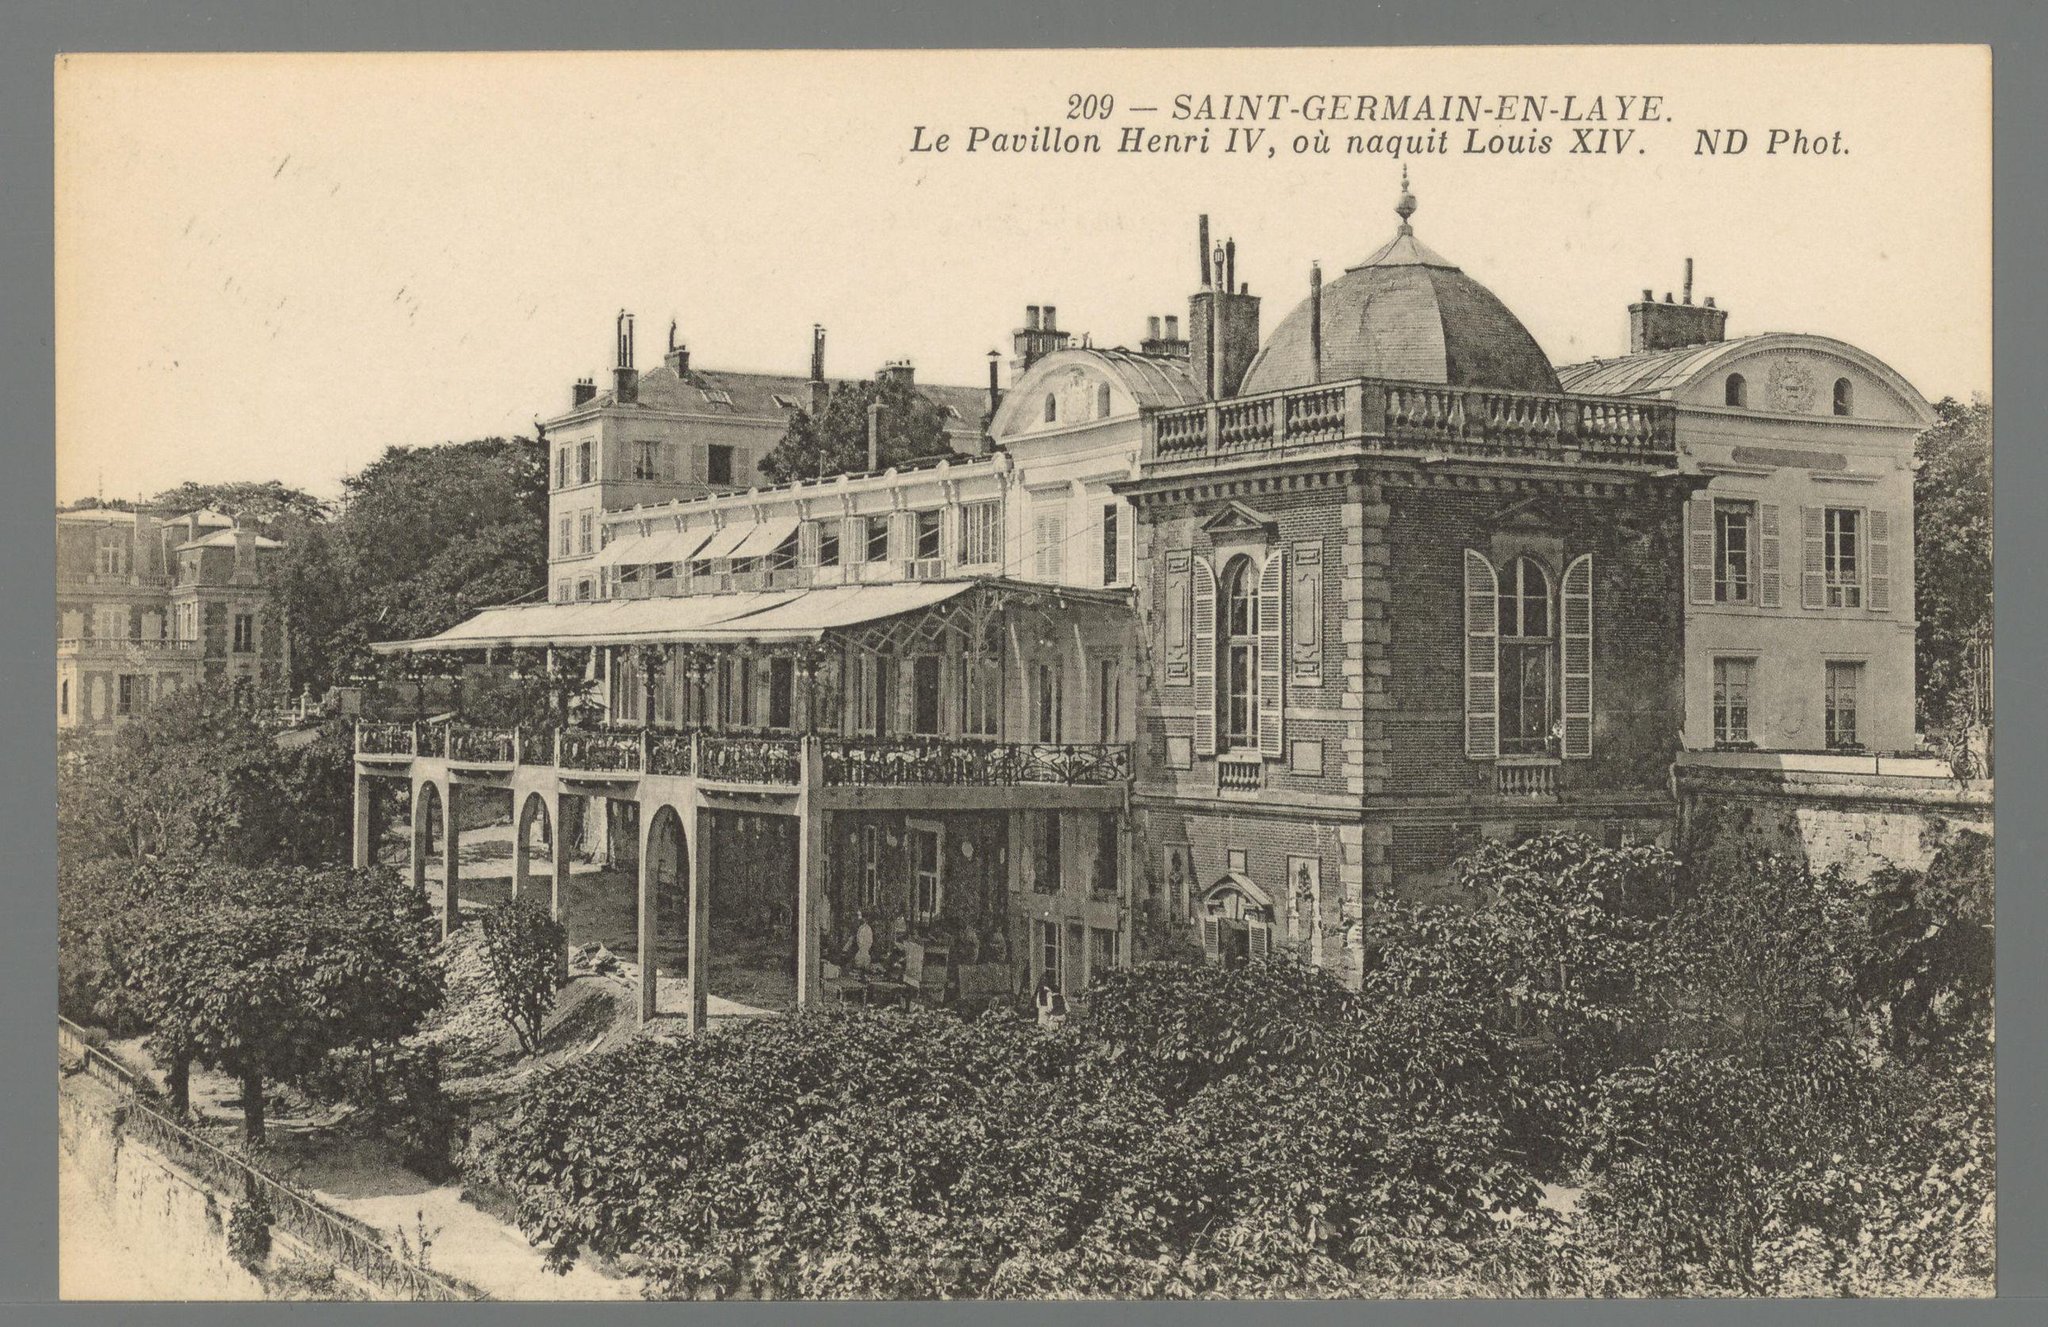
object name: ansichtkaart, prentbriefkaart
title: Saint-Germain-en-Laye. Le Pavillon Henri IV, où naquit Louis XIV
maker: Anonymous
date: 1903-1918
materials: cardboard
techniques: photograph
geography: saint-germain-en-laye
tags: park, palace